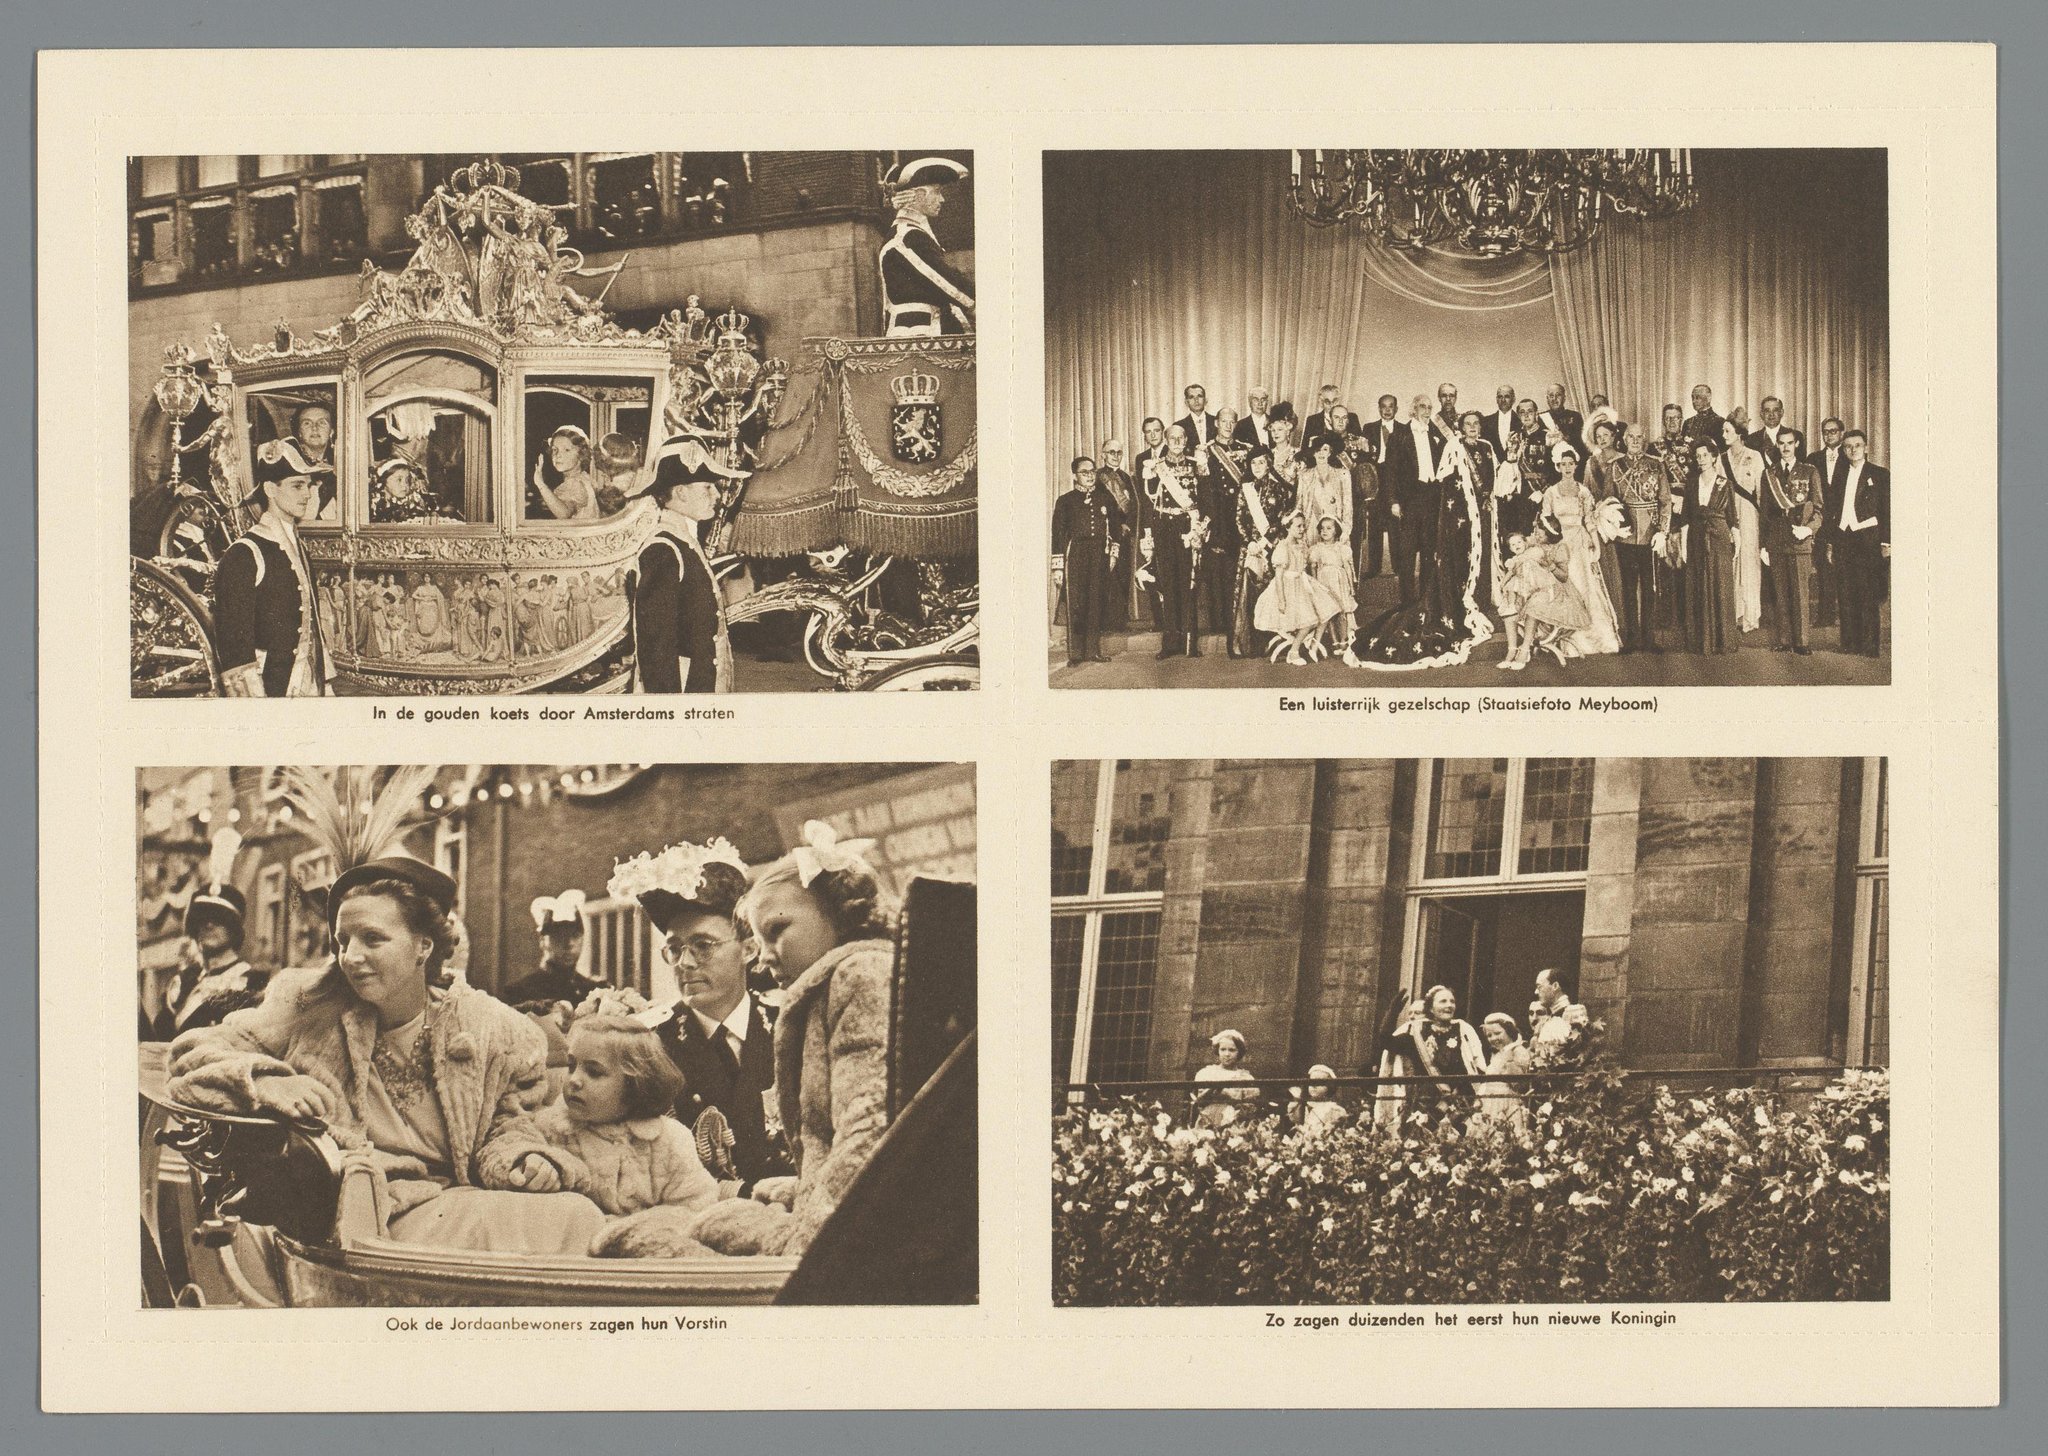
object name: photomechanical print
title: Ook de Jordaanbewoners zagen hun Vorstin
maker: Anonymous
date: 1949-1951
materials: paper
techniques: rotogravure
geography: alphen aan den rijn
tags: the hague, juliana of the netherlands, coronation of a ruler, netherlands